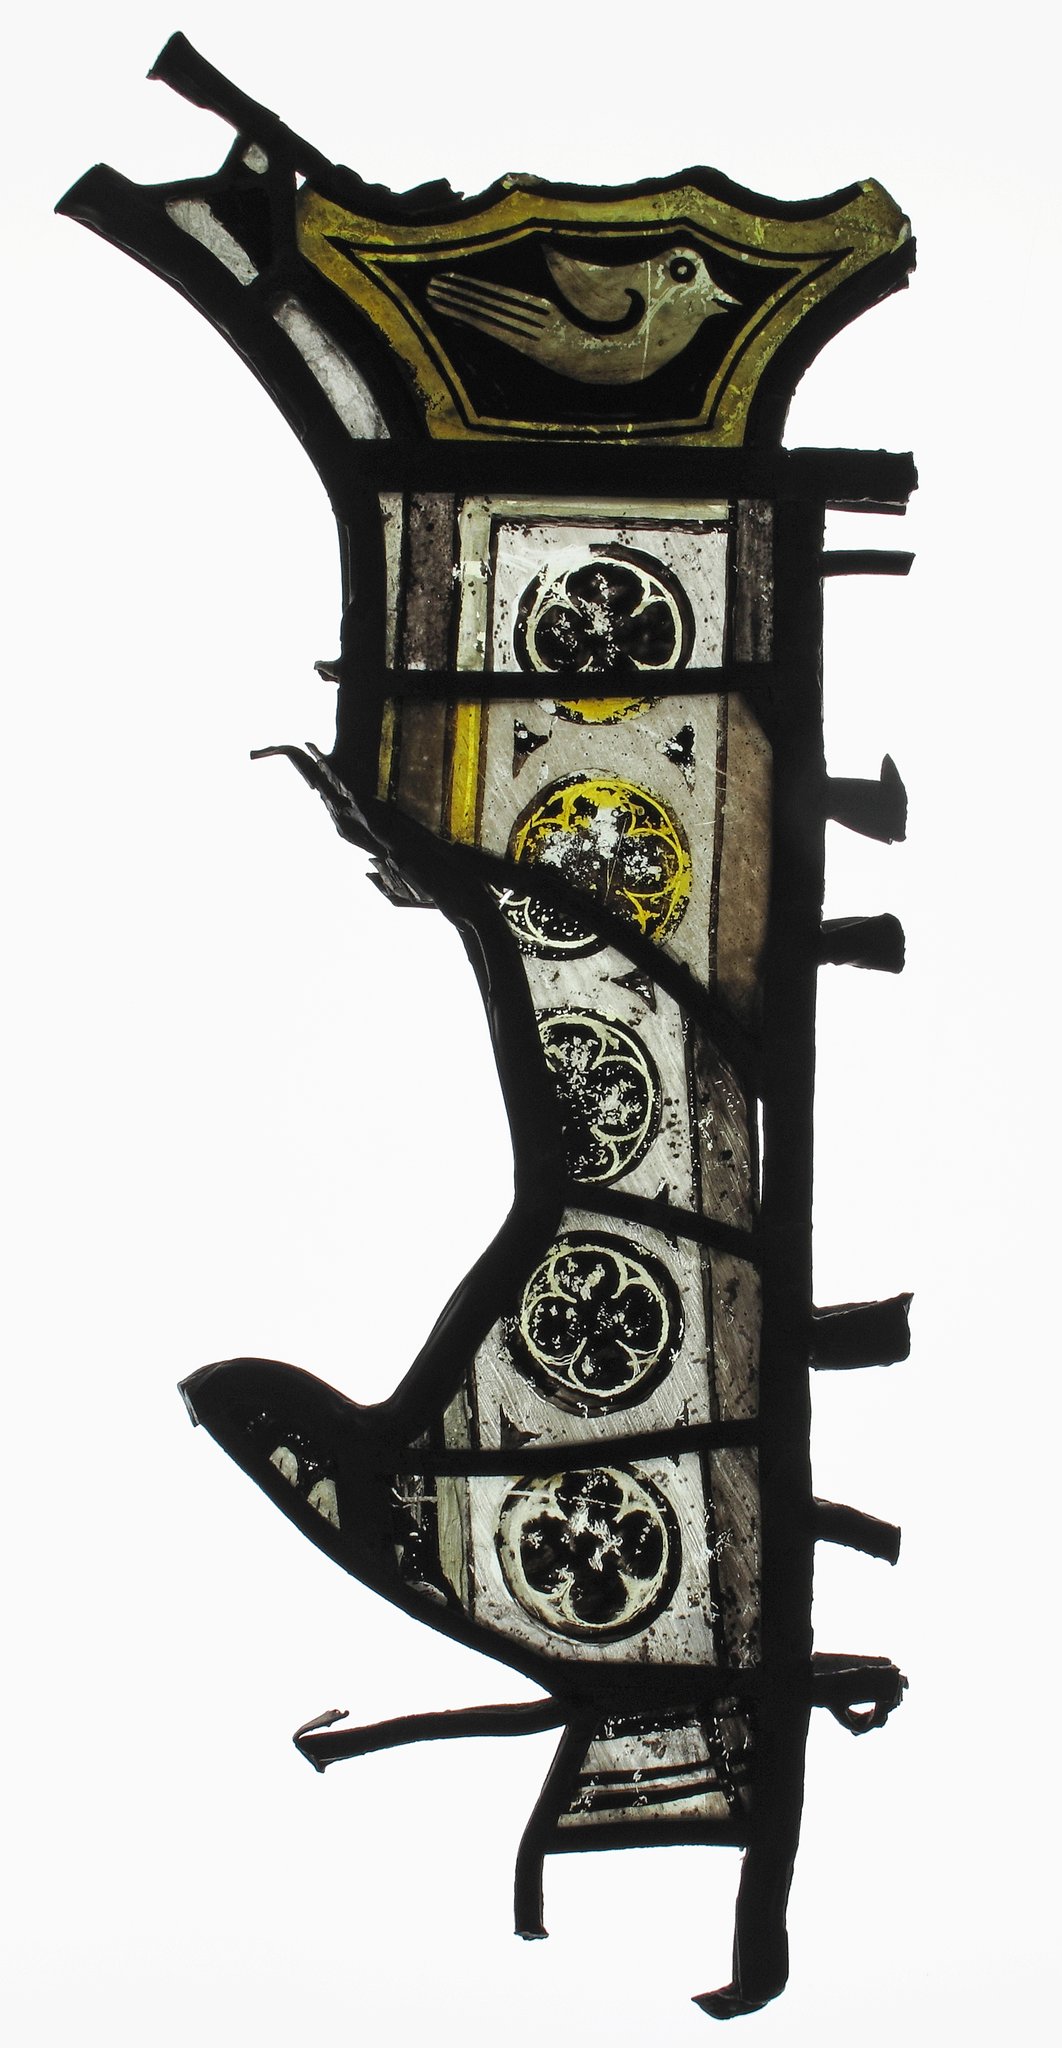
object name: fragment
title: Glass Fragment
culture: european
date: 1401-1500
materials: glass